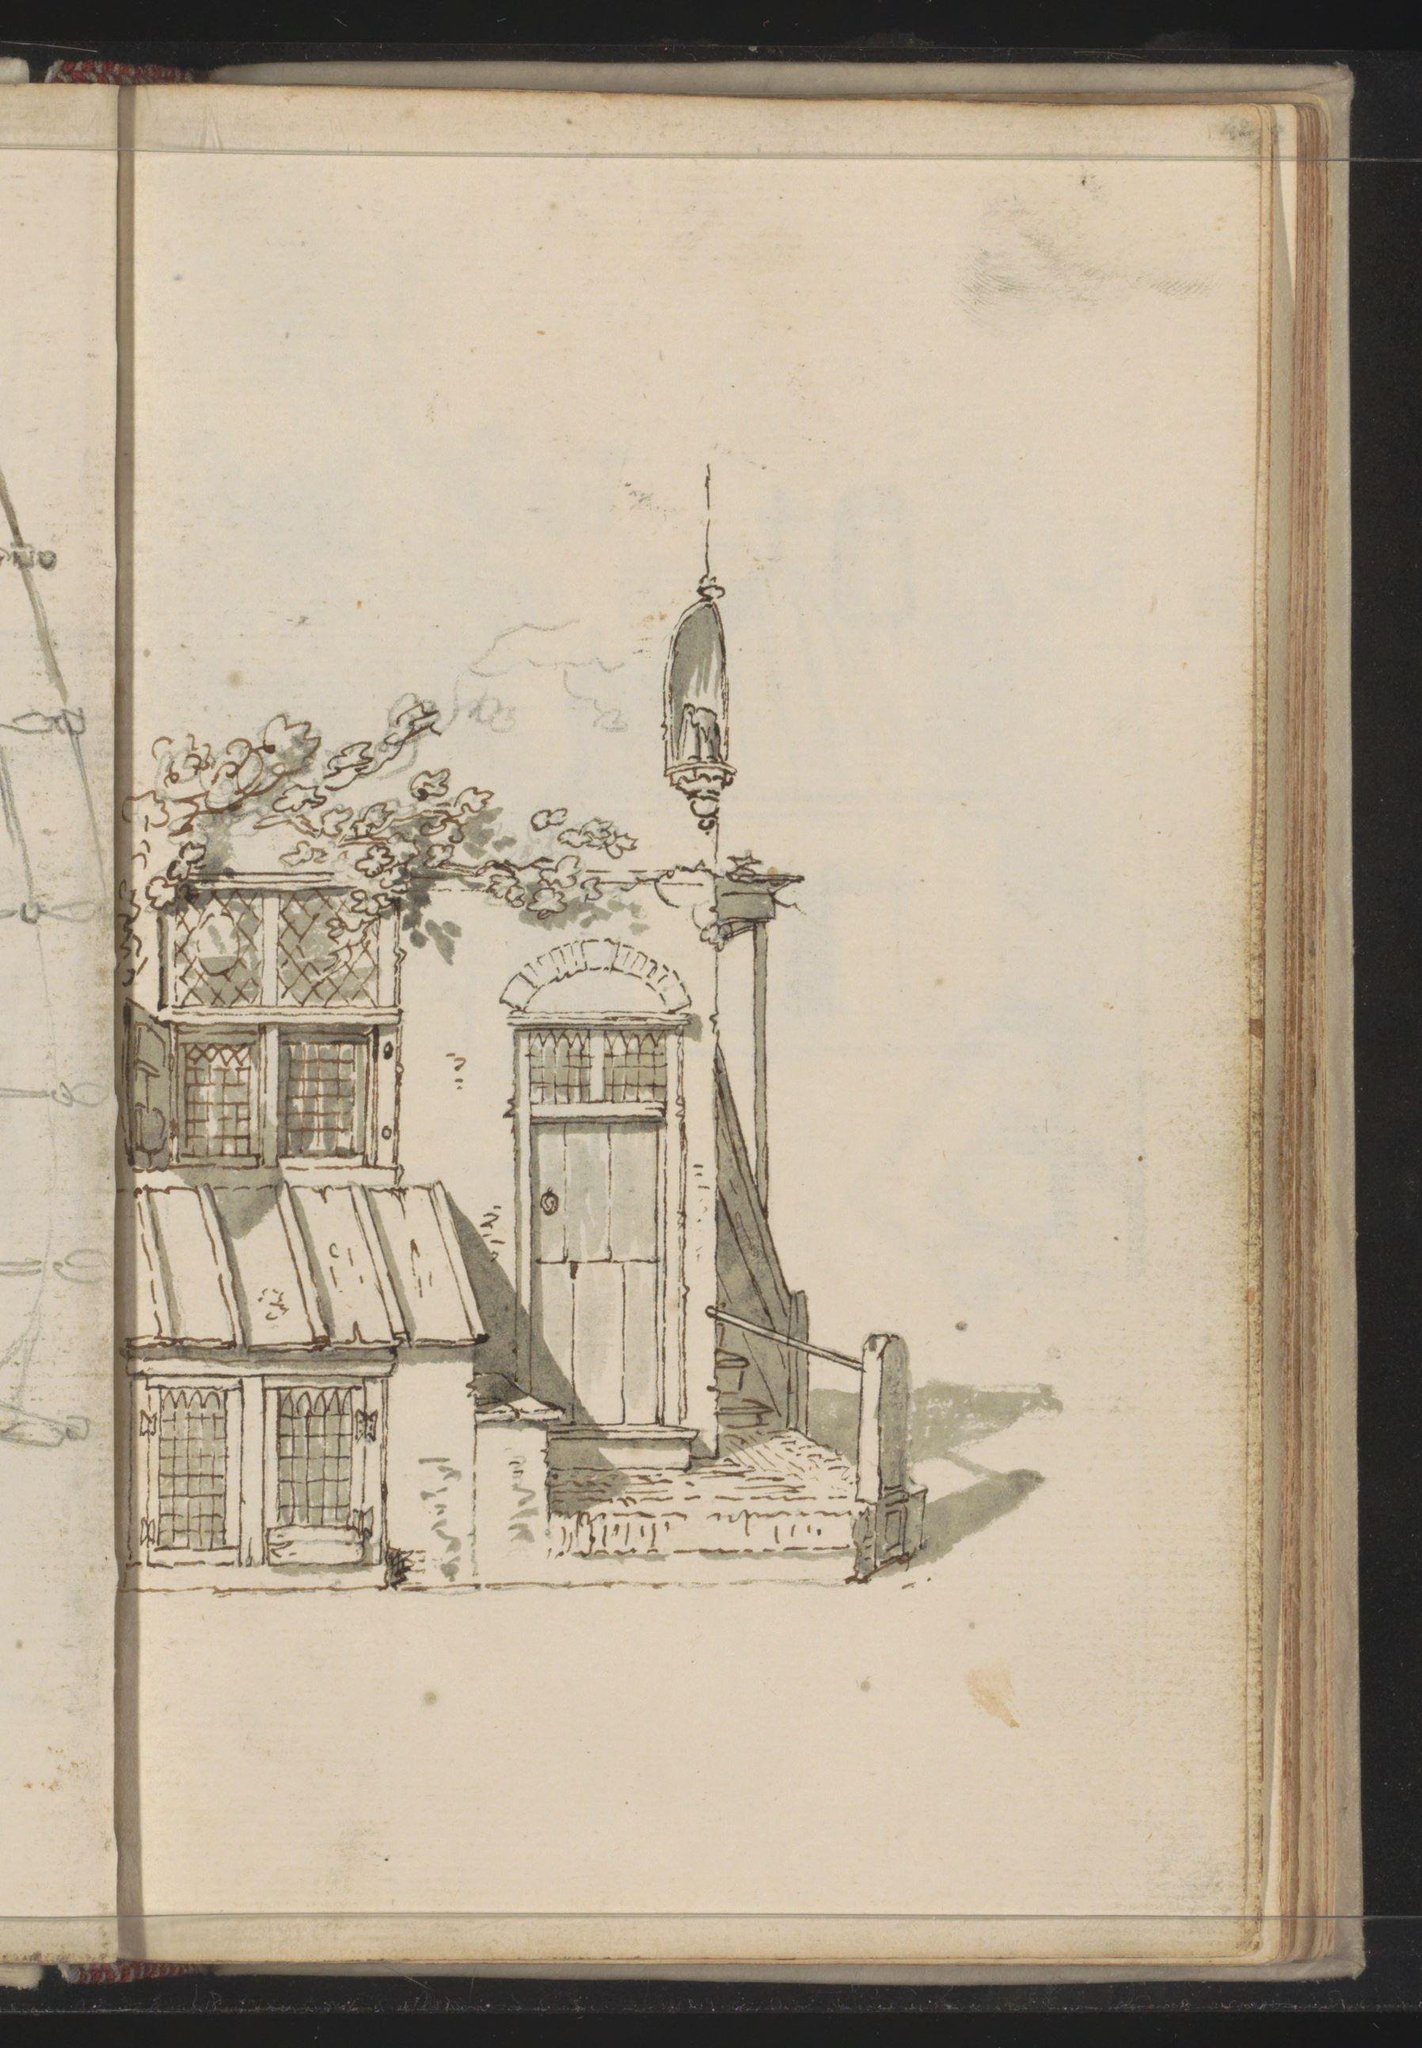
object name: sketchbook leaf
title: Voorgevel van een huis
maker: johannes huibert prins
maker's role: draughtsman, painter, print maker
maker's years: 1757-1806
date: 1783-1797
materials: ink, paper, pencil, watercolor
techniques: brush, pen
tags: façade (of house or building)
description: Pagina 42 uit een schetsboek met 175 pagina's.